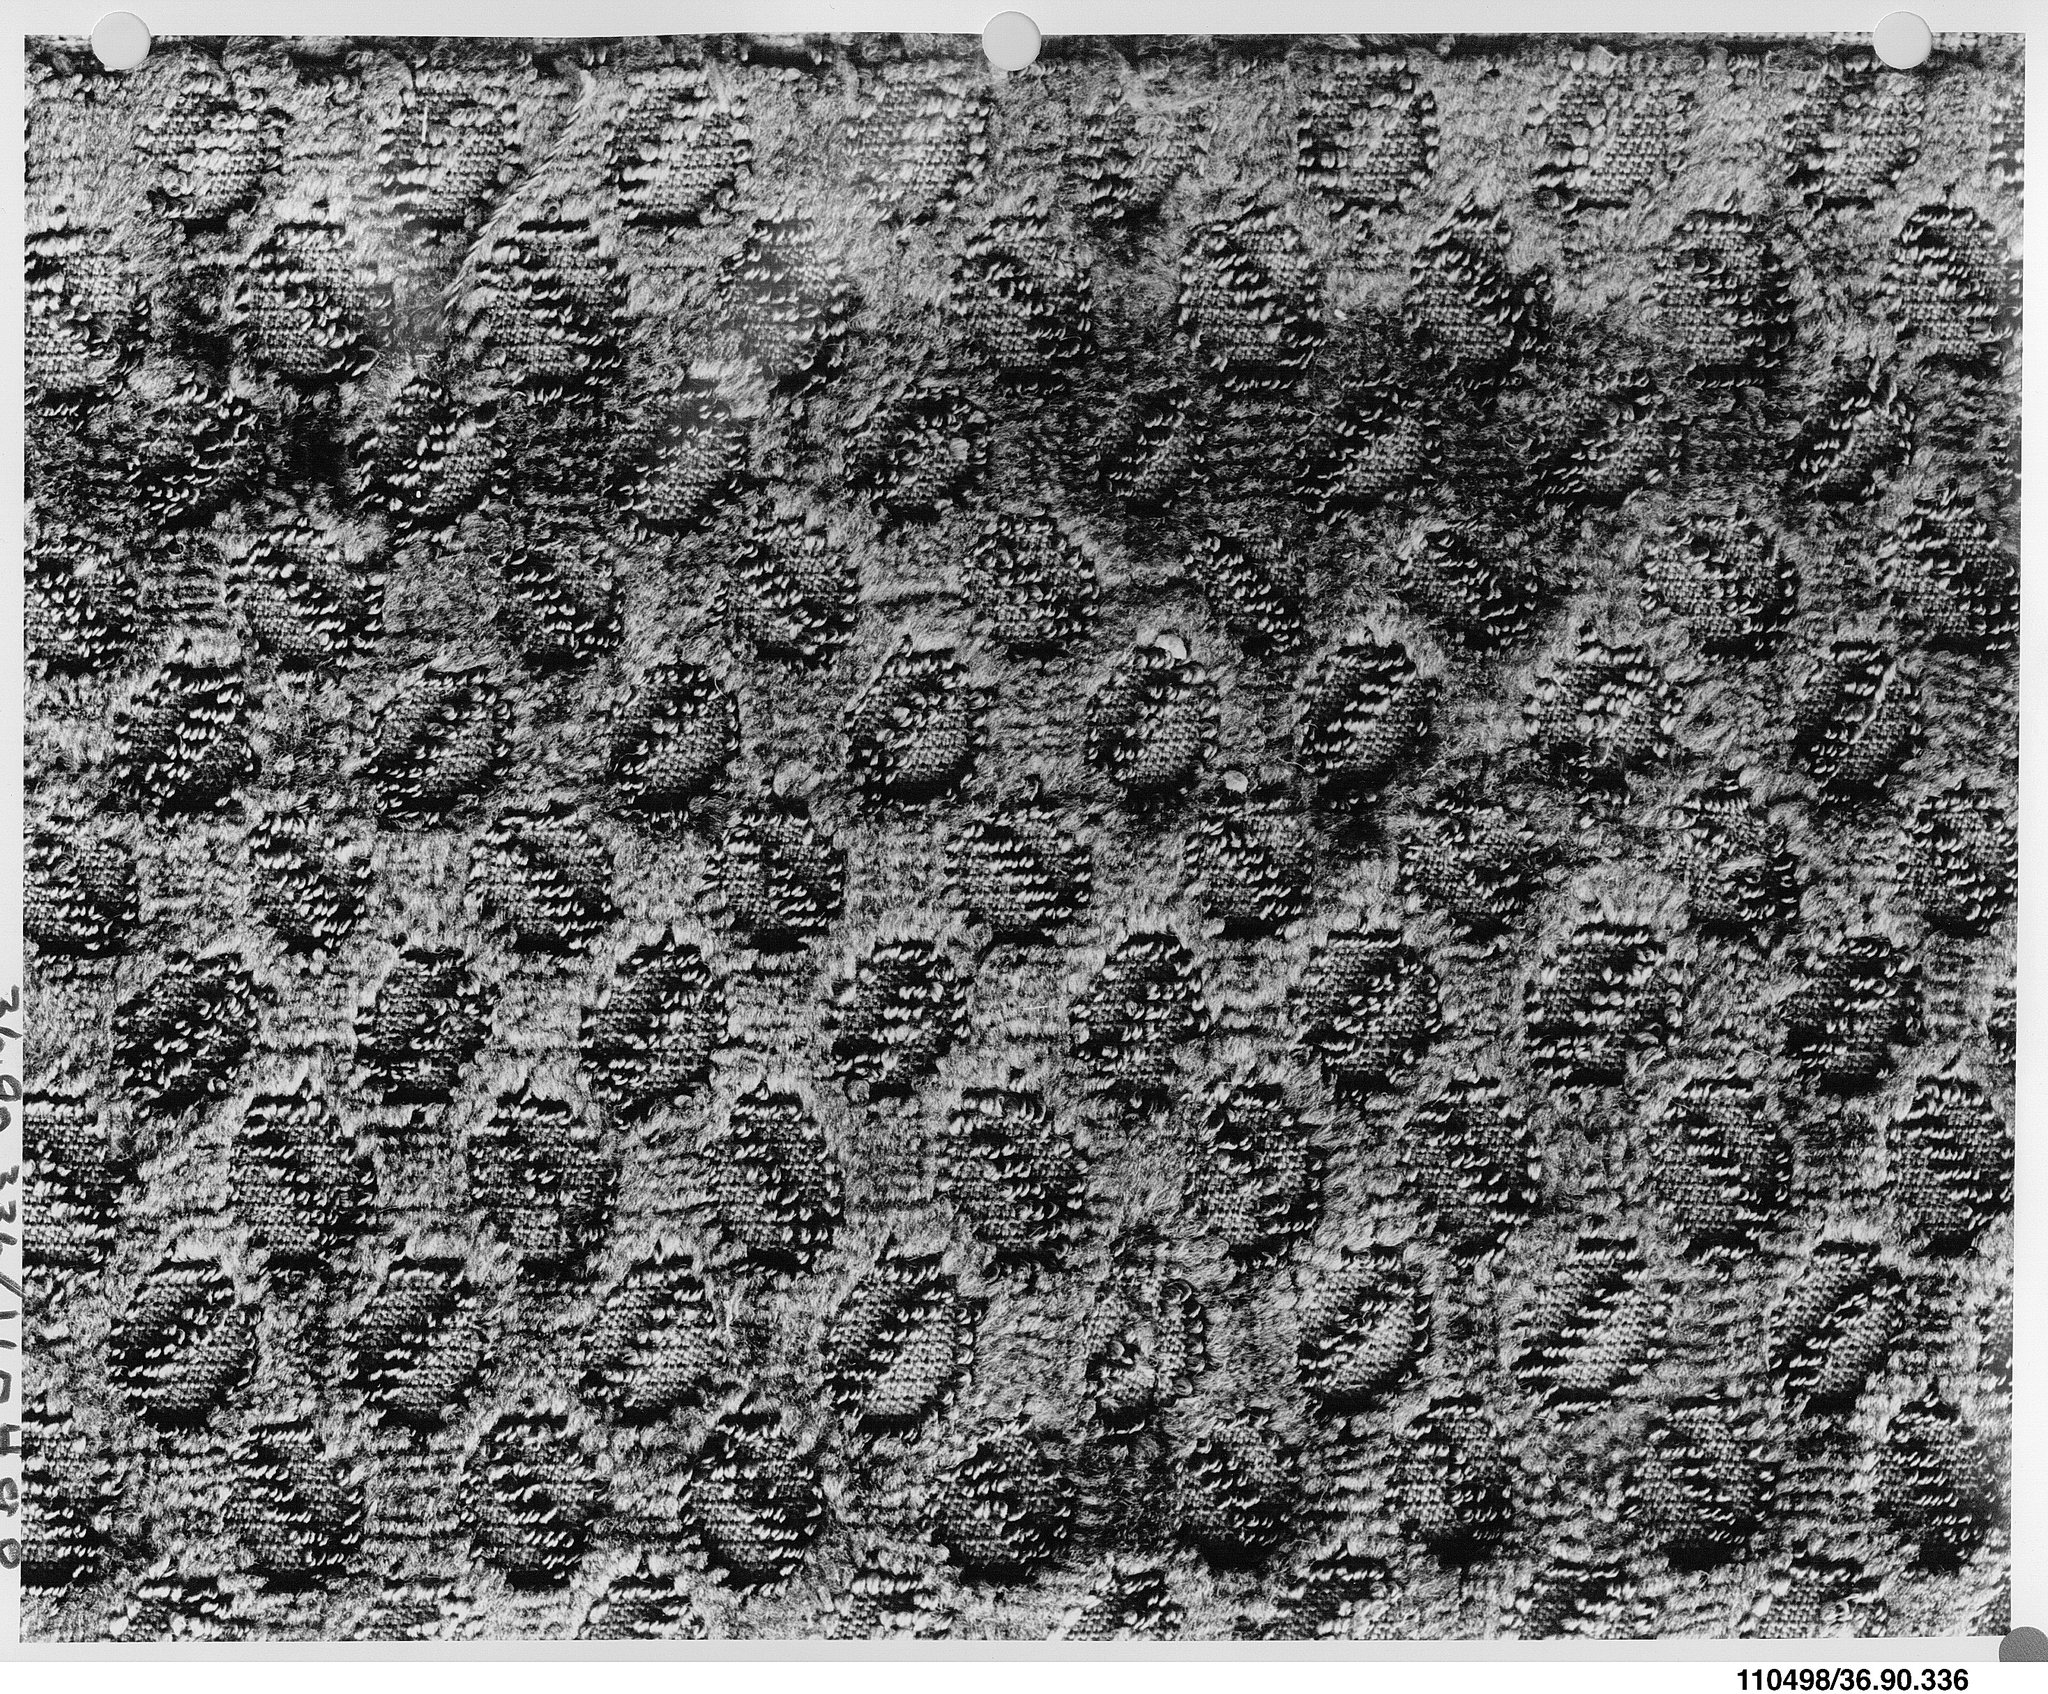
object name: piece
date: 1501-1700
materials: silk